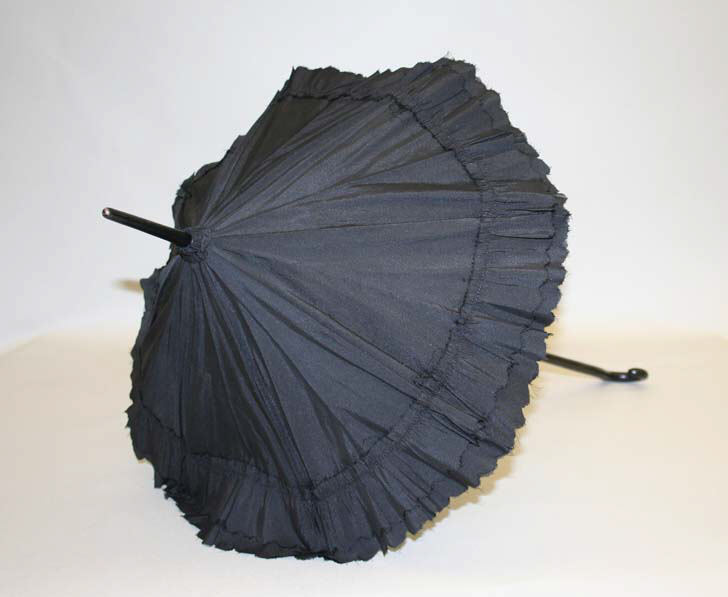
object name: parasol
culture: american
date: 1860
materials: silk